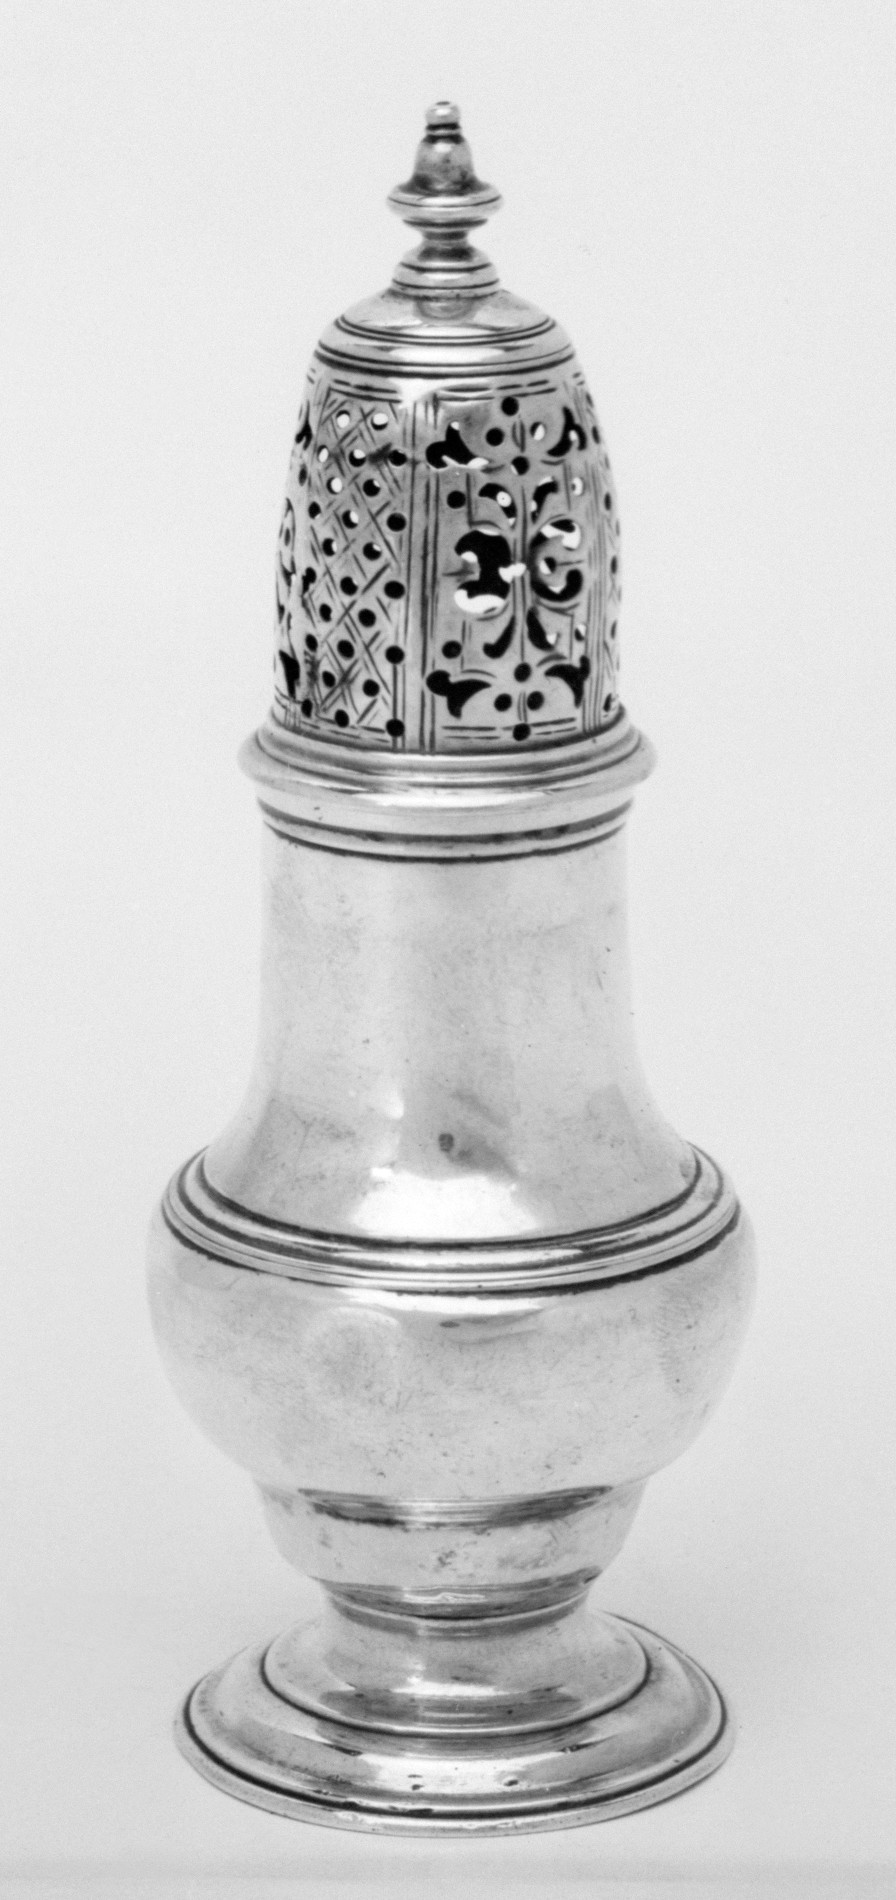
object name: caster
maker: jabez daniel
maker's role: maker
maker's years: 1749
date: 1751-1752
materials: silver